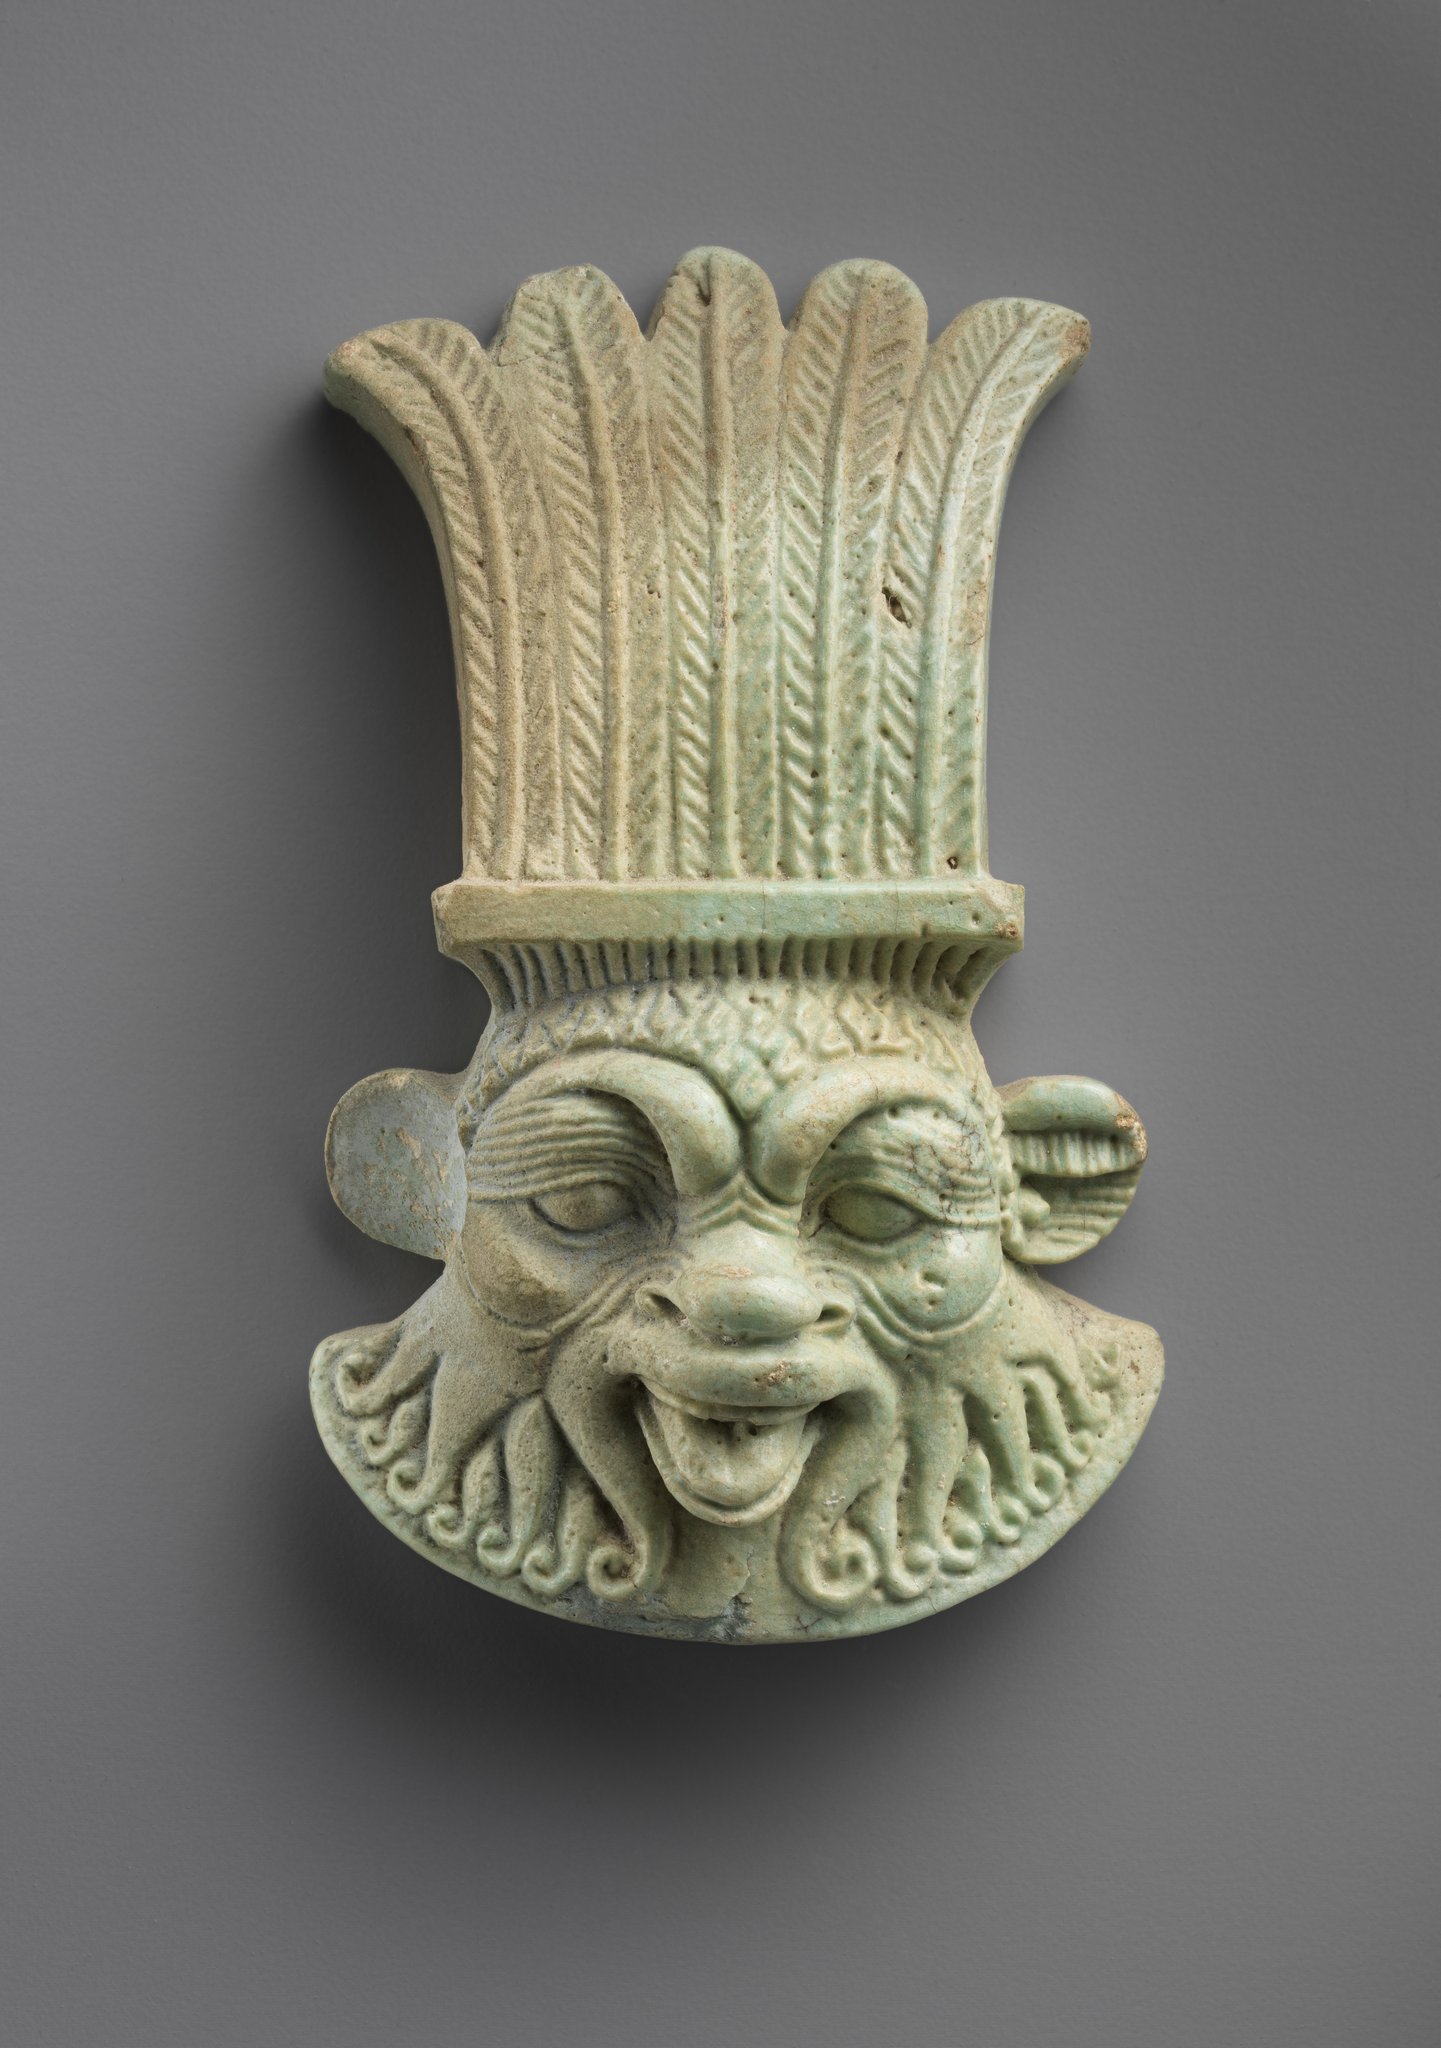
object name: amulet, be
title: Bes-image pendant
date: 664-525 BCE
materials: faience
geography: egypt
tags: bes